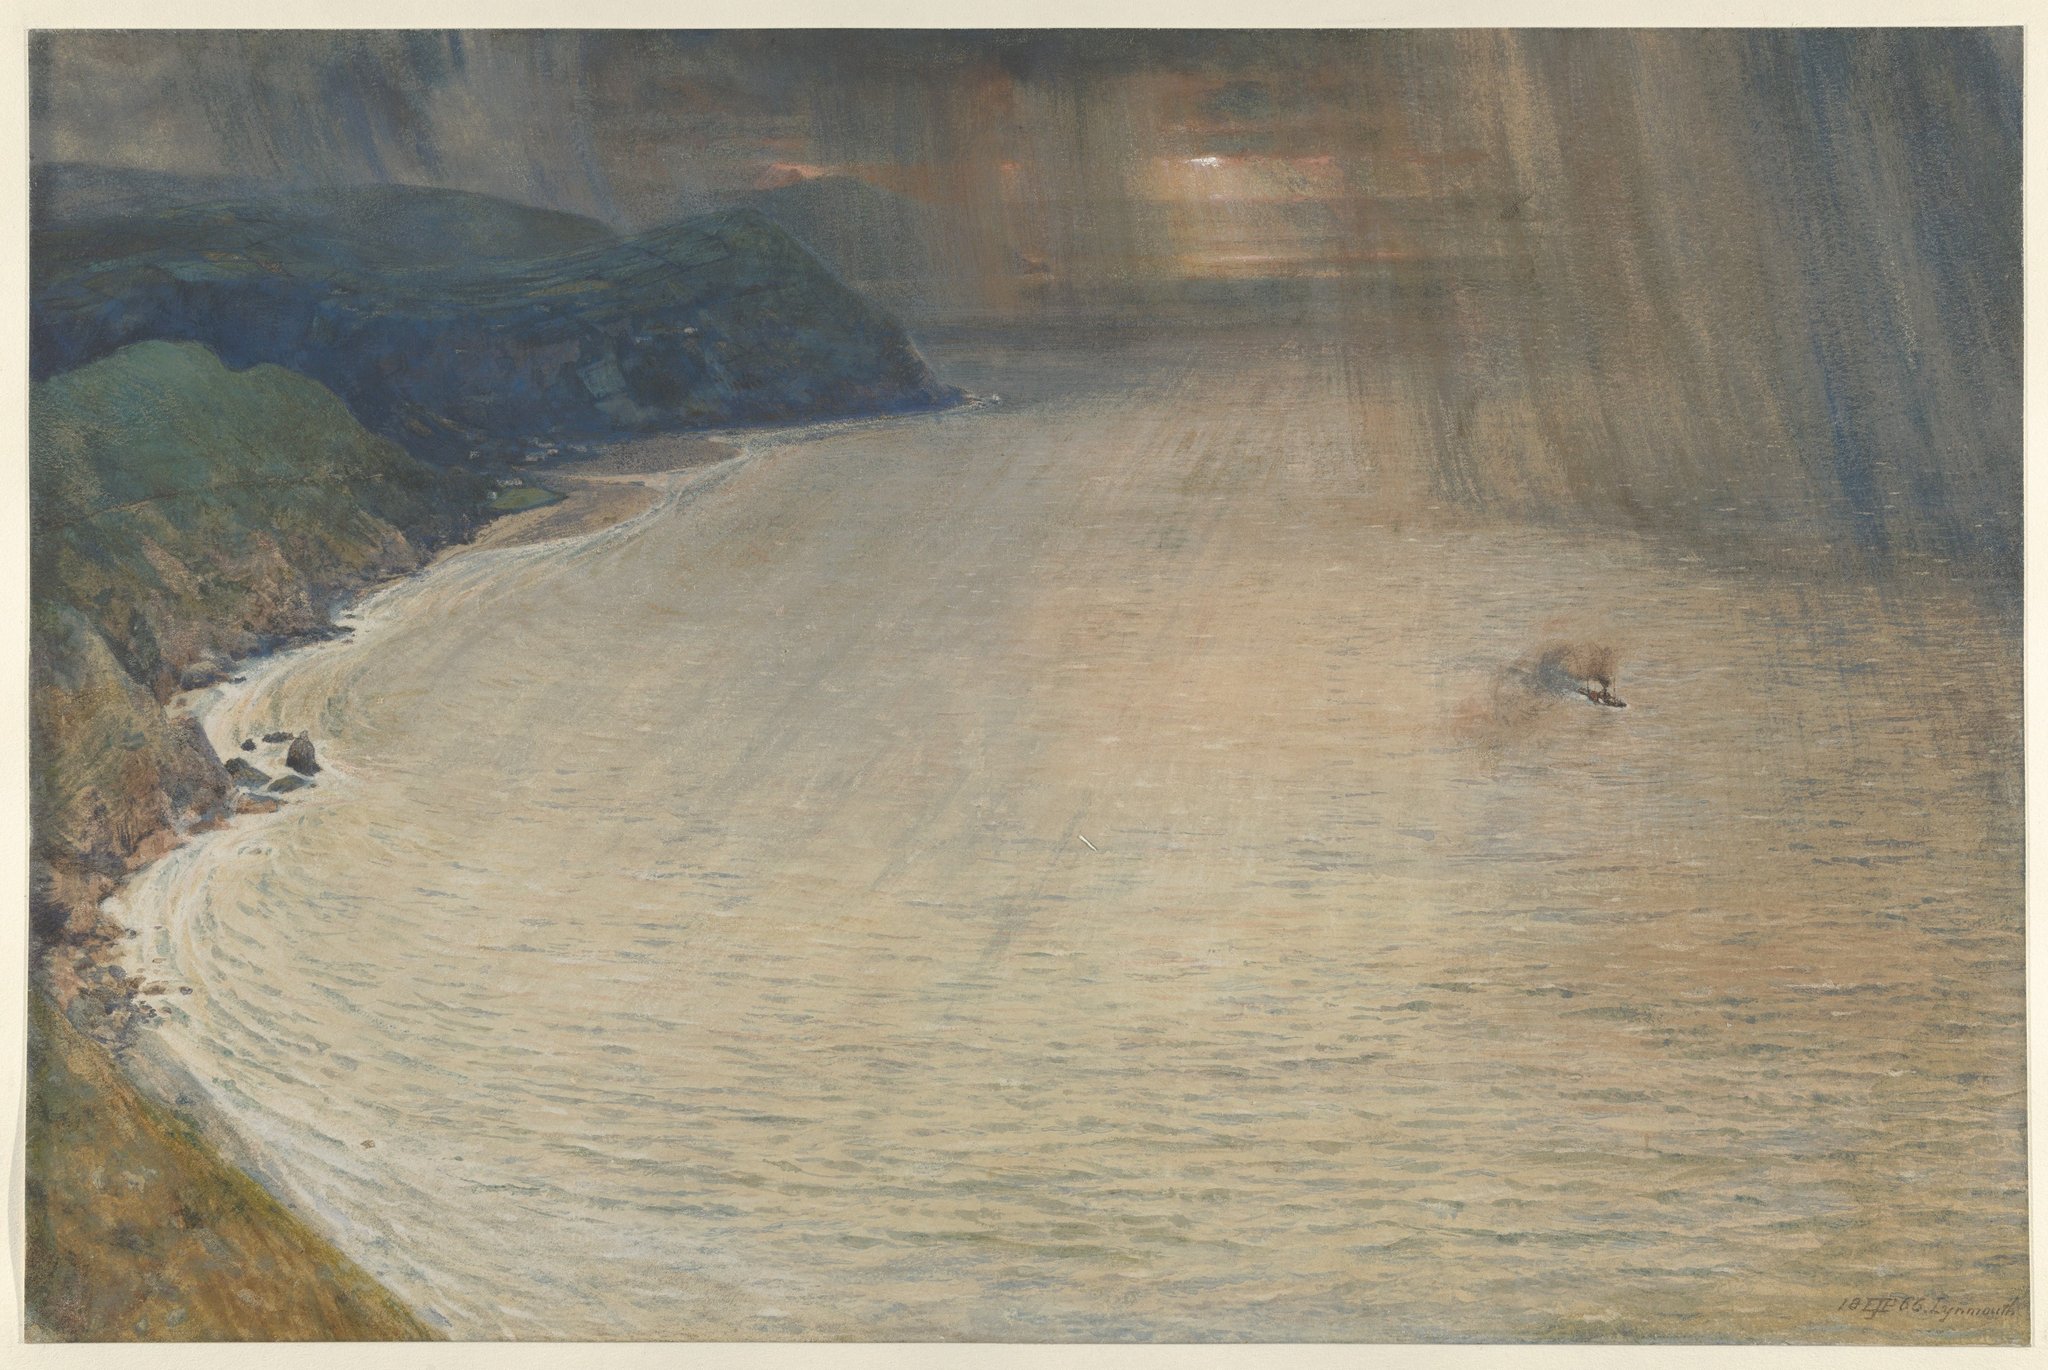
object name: drawing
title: The West Wind, Lynmouth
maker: sir edward john poynter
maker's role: artist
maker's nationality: british, born france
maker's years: 1836-1919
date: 1866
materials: gouache, watercolor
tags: rivers,landscapes,rain,wind